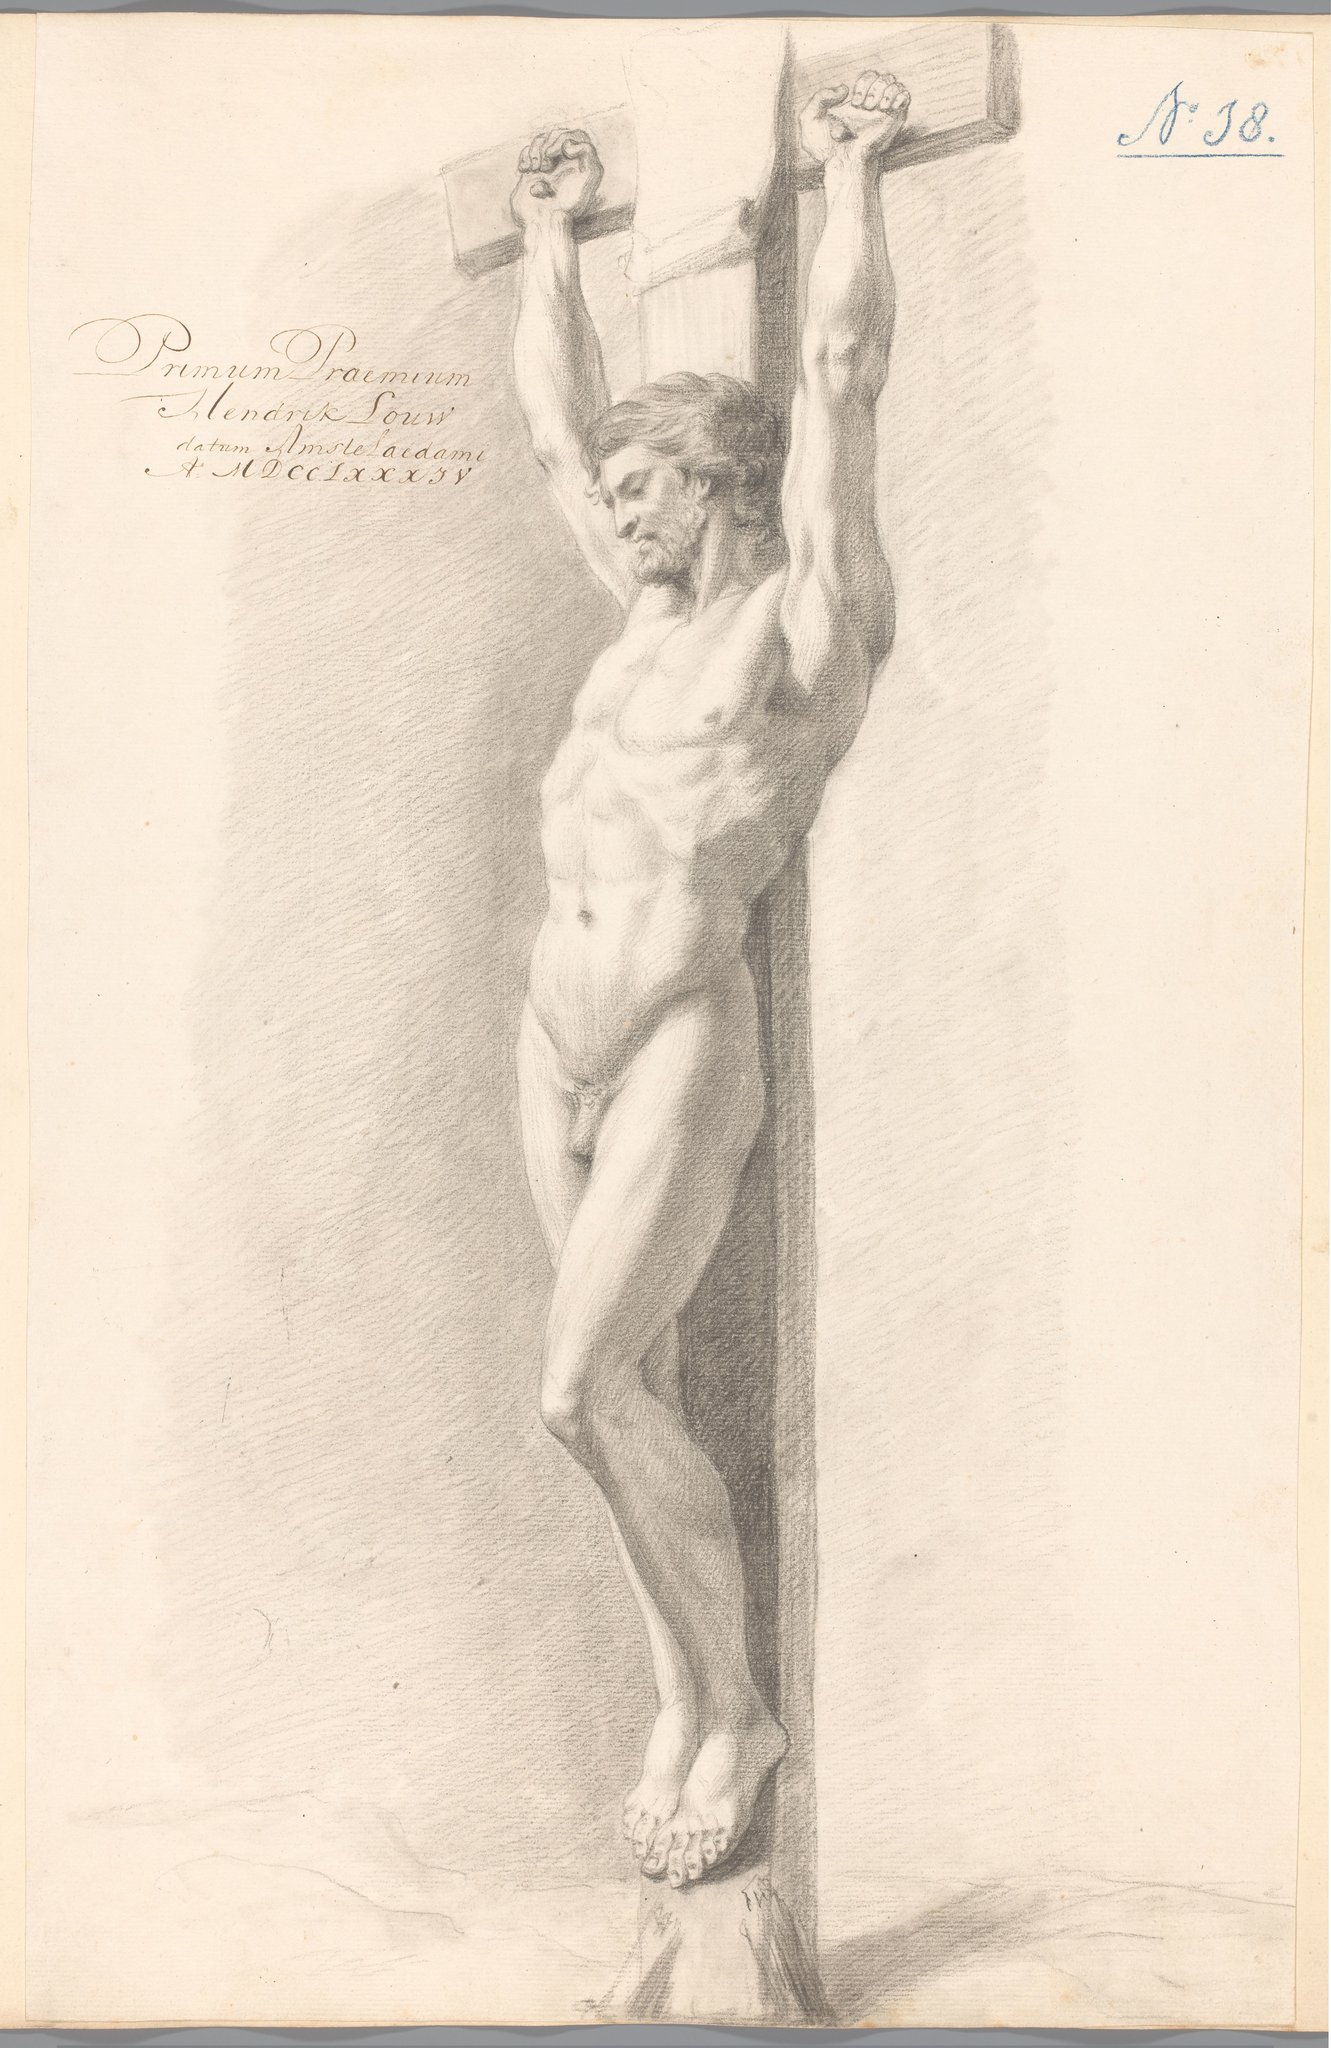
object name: drawing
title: Christus aan het kruis (1e prijs 1784)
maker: hendrik louw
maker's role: draughtsman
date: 1784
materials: chalk, paper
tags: standing figure (+ nude human being), specific types of crucified christ (in non-narrative context)